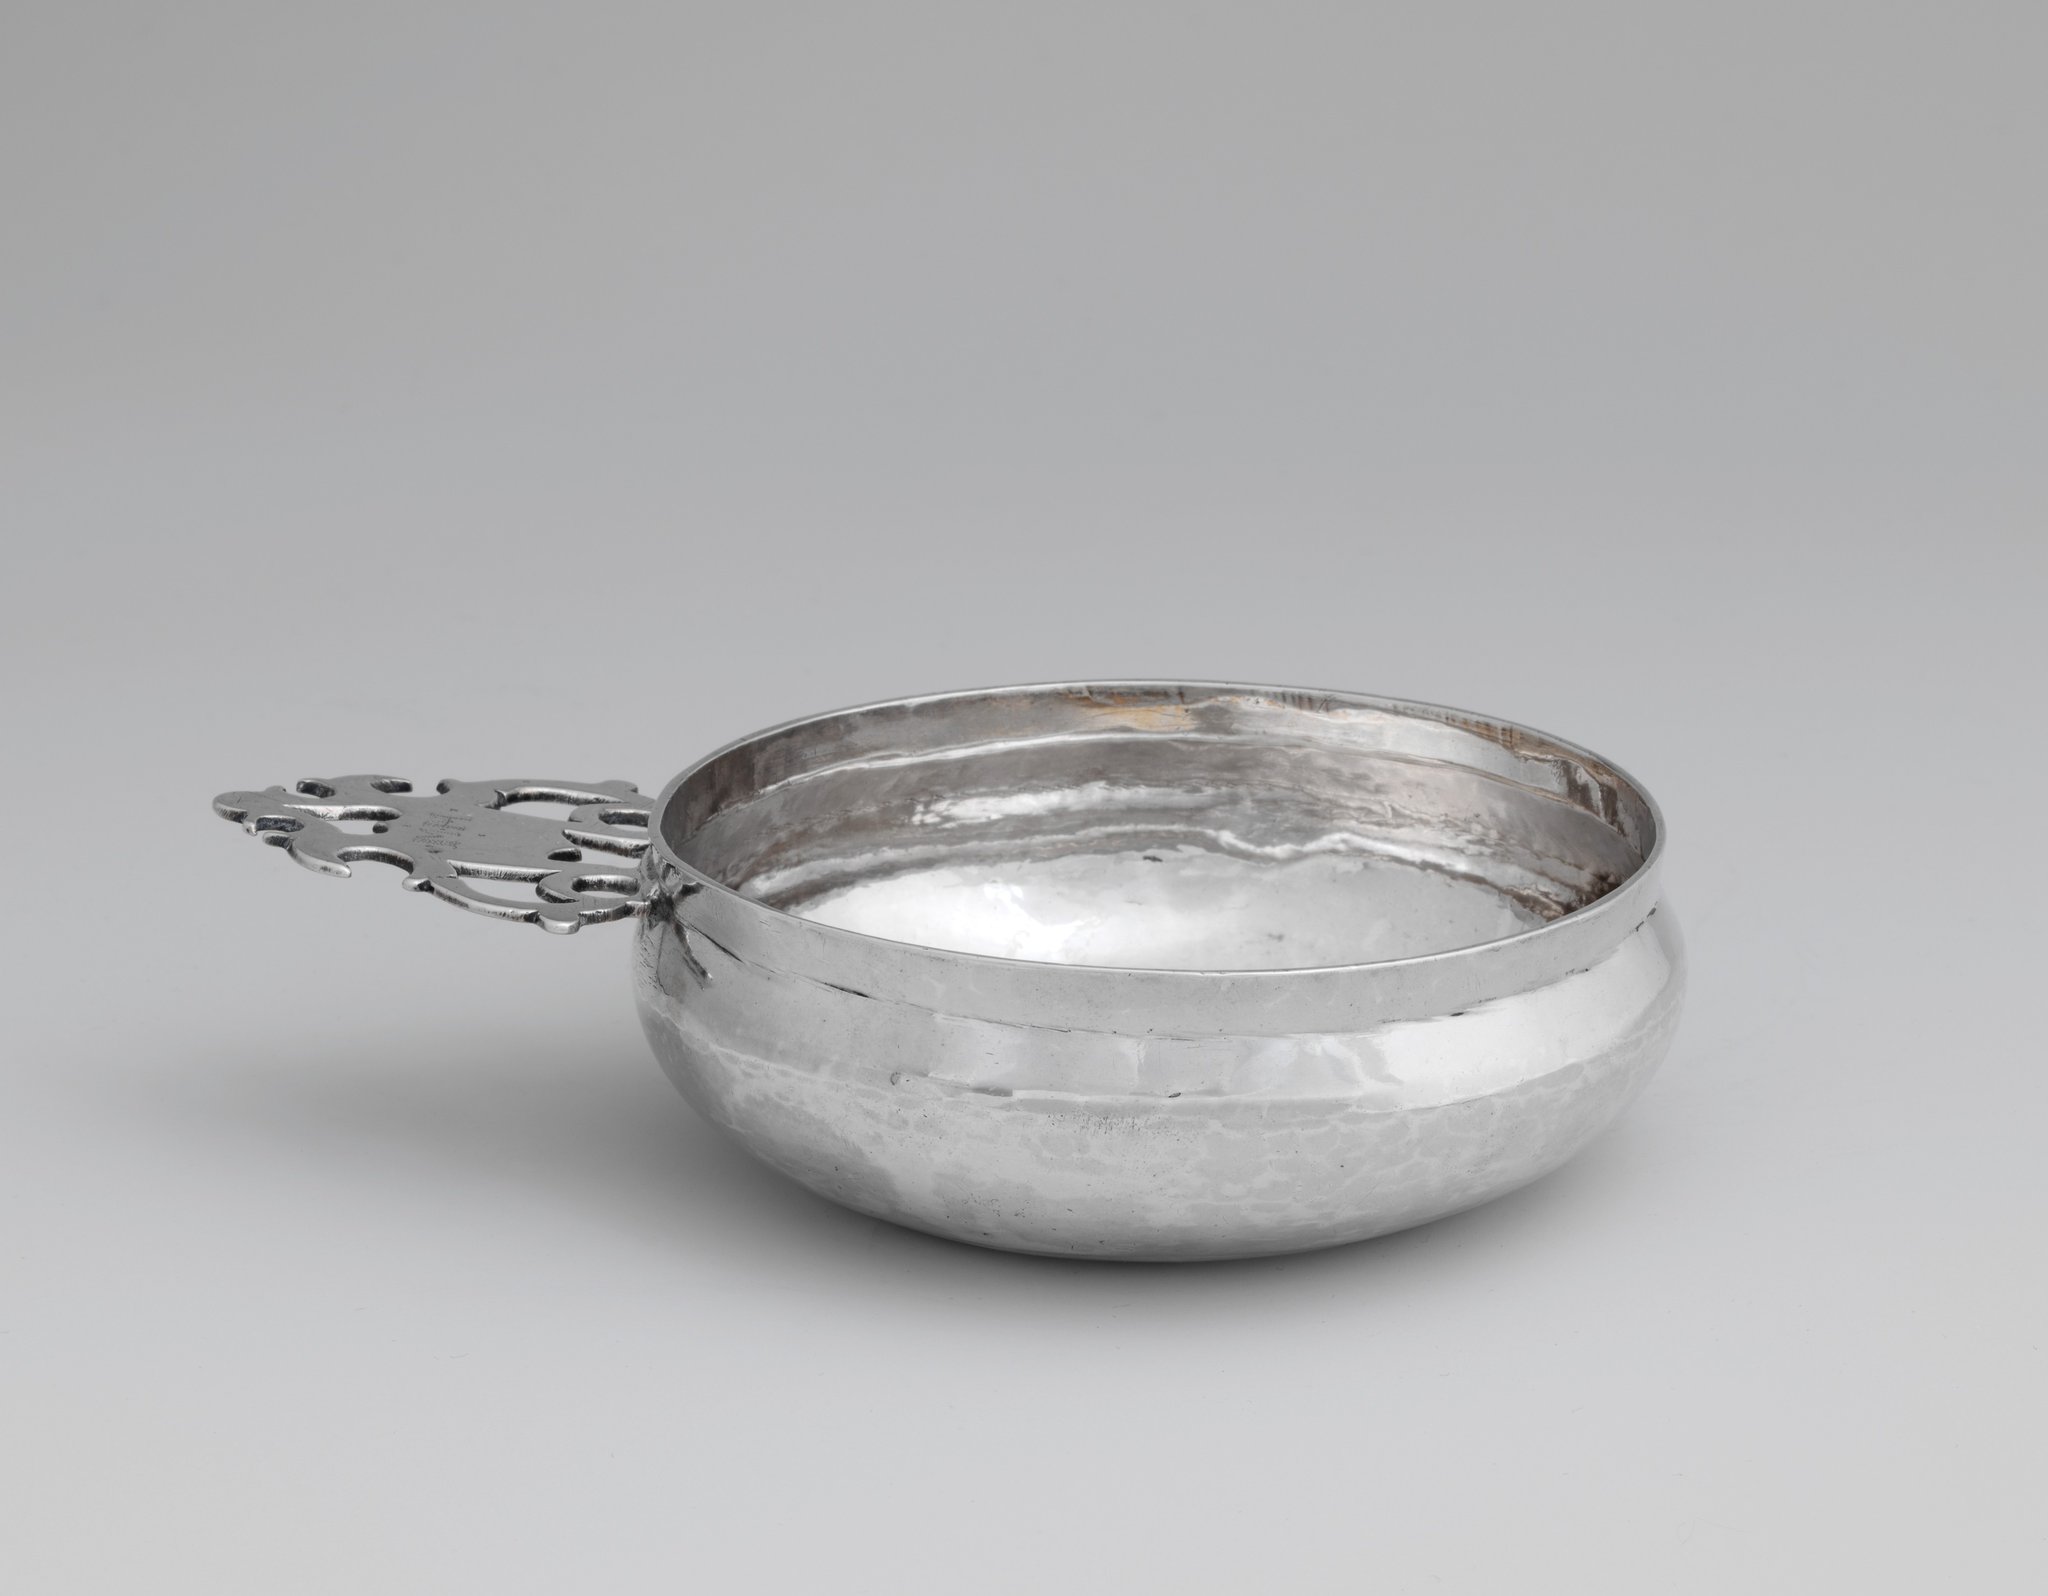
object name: porringer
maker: thomas cory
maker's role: maker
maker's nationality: british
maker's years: 1655-1689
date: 1685-1686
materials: silver